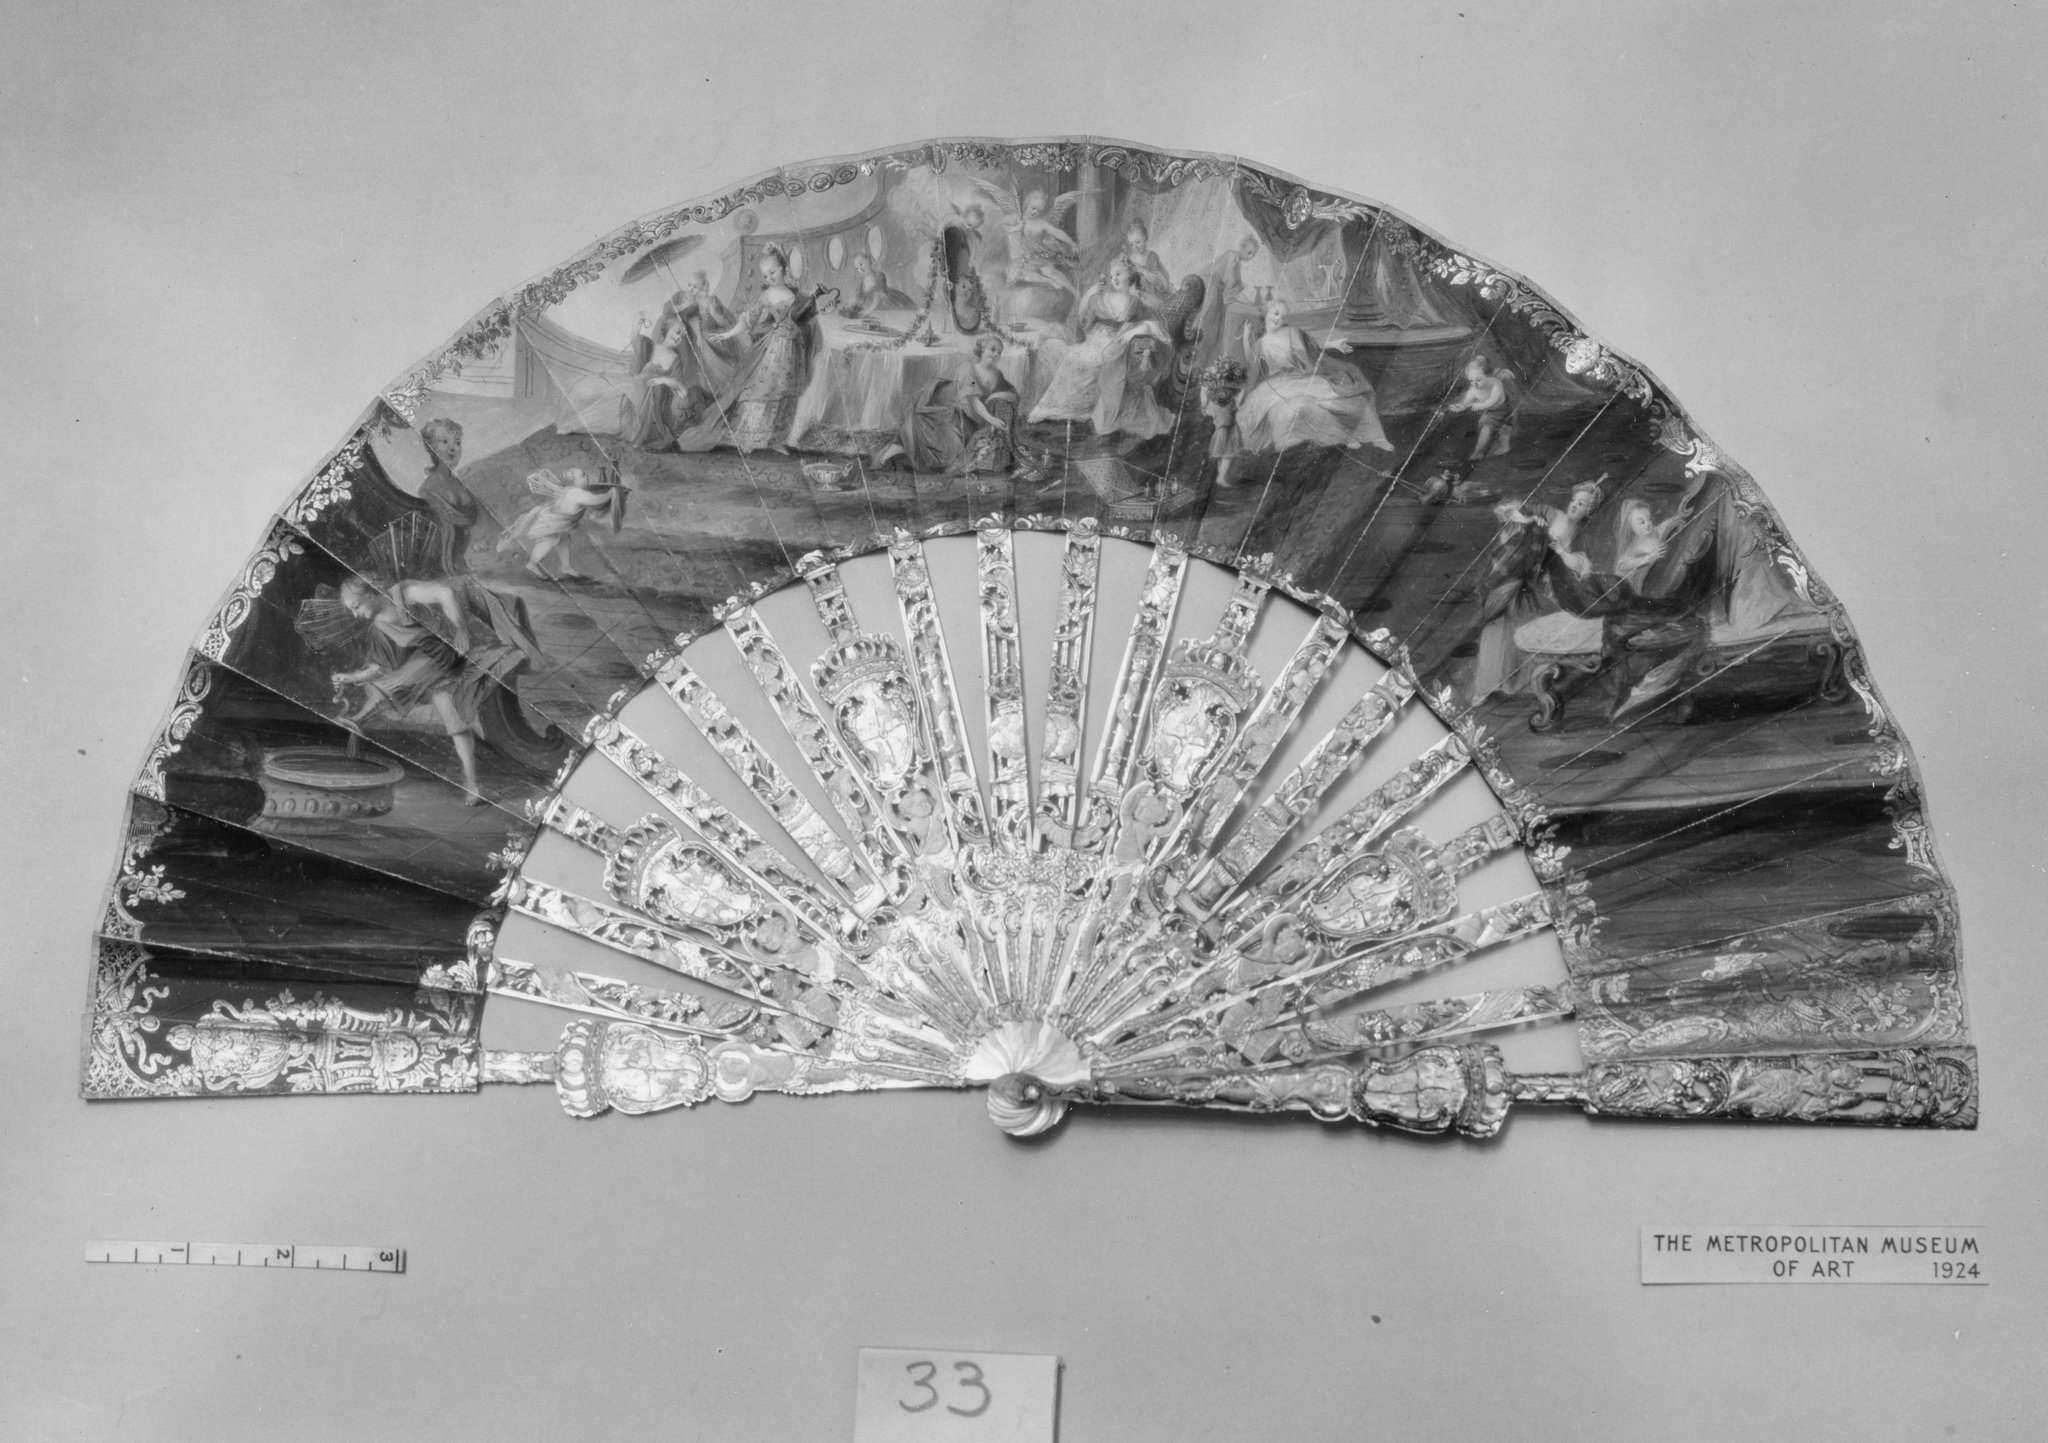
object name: fan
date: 1725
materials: paper, pearl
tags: women,cupid